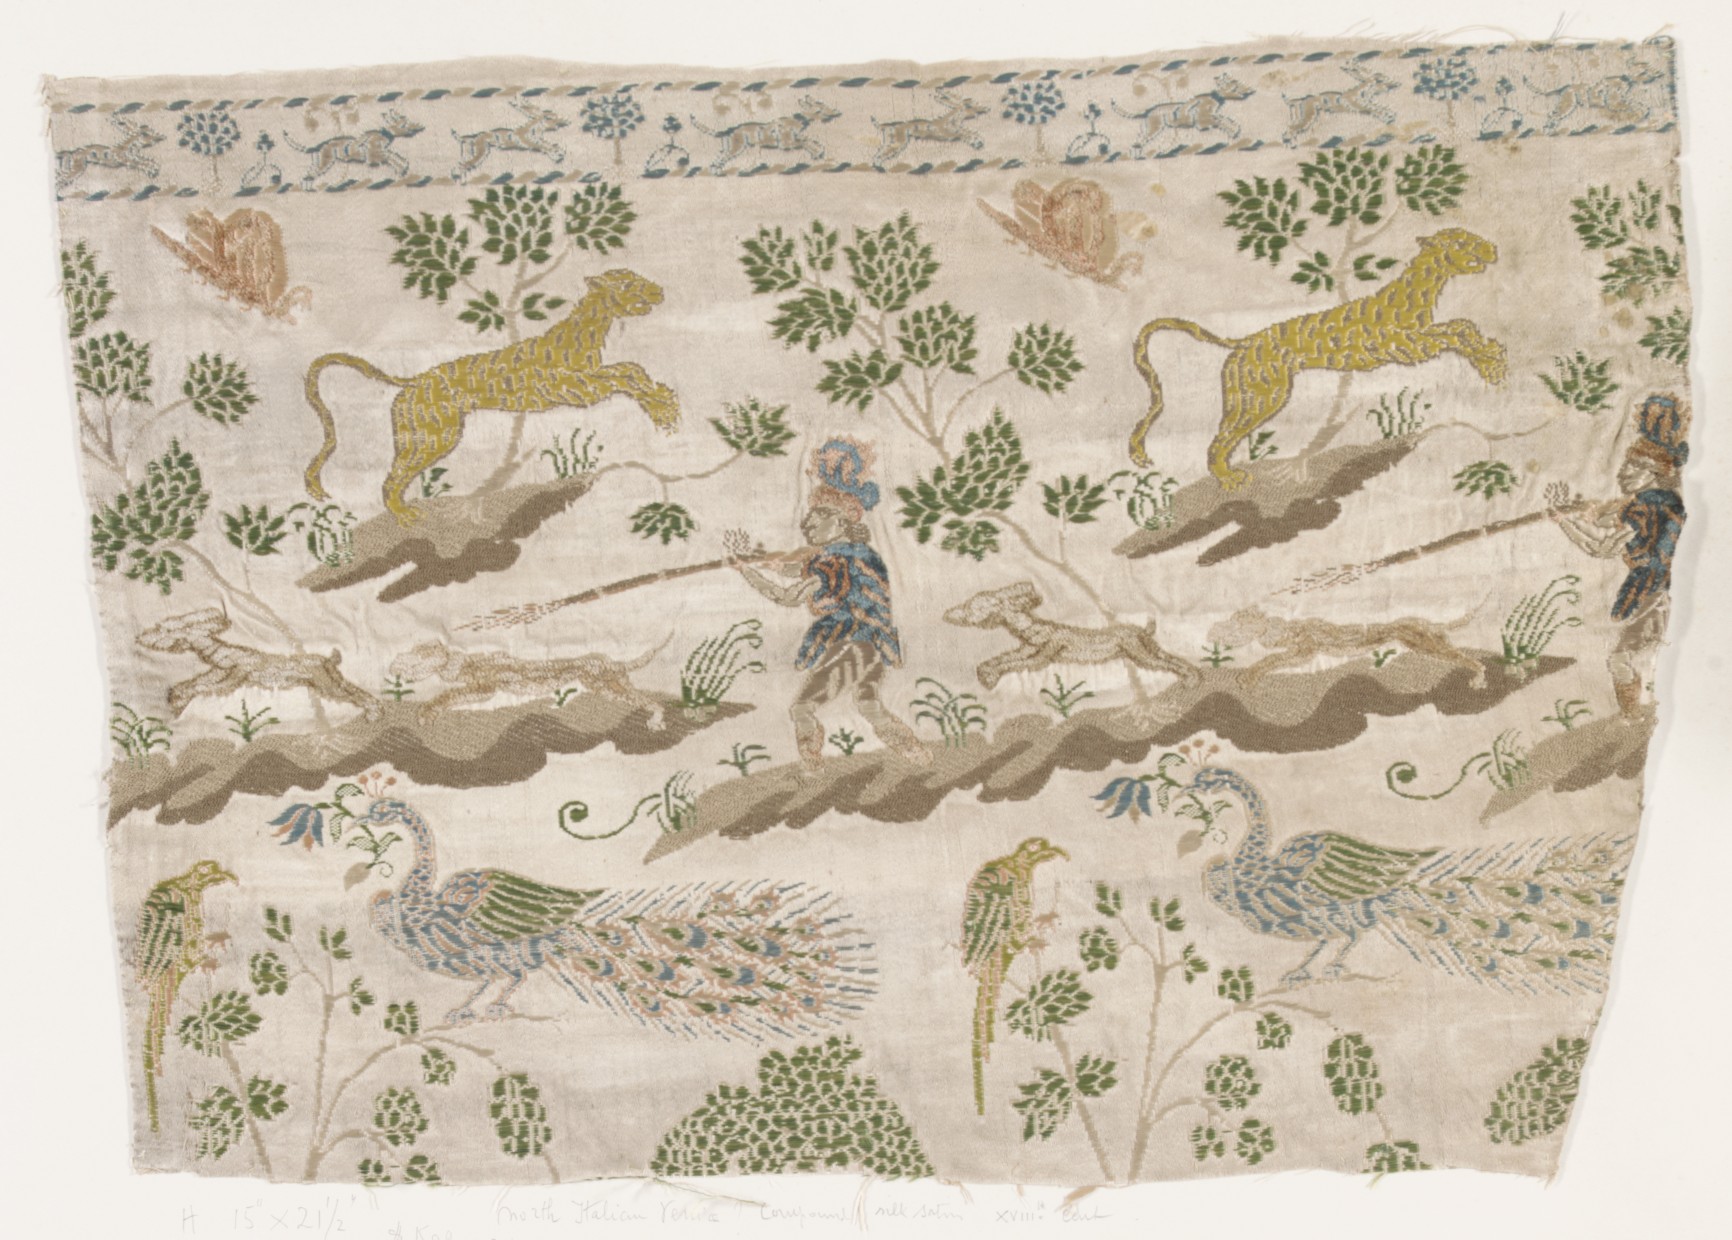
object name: fragment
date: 1701-1800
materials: silk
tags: animals,hunting,peacocks,trees